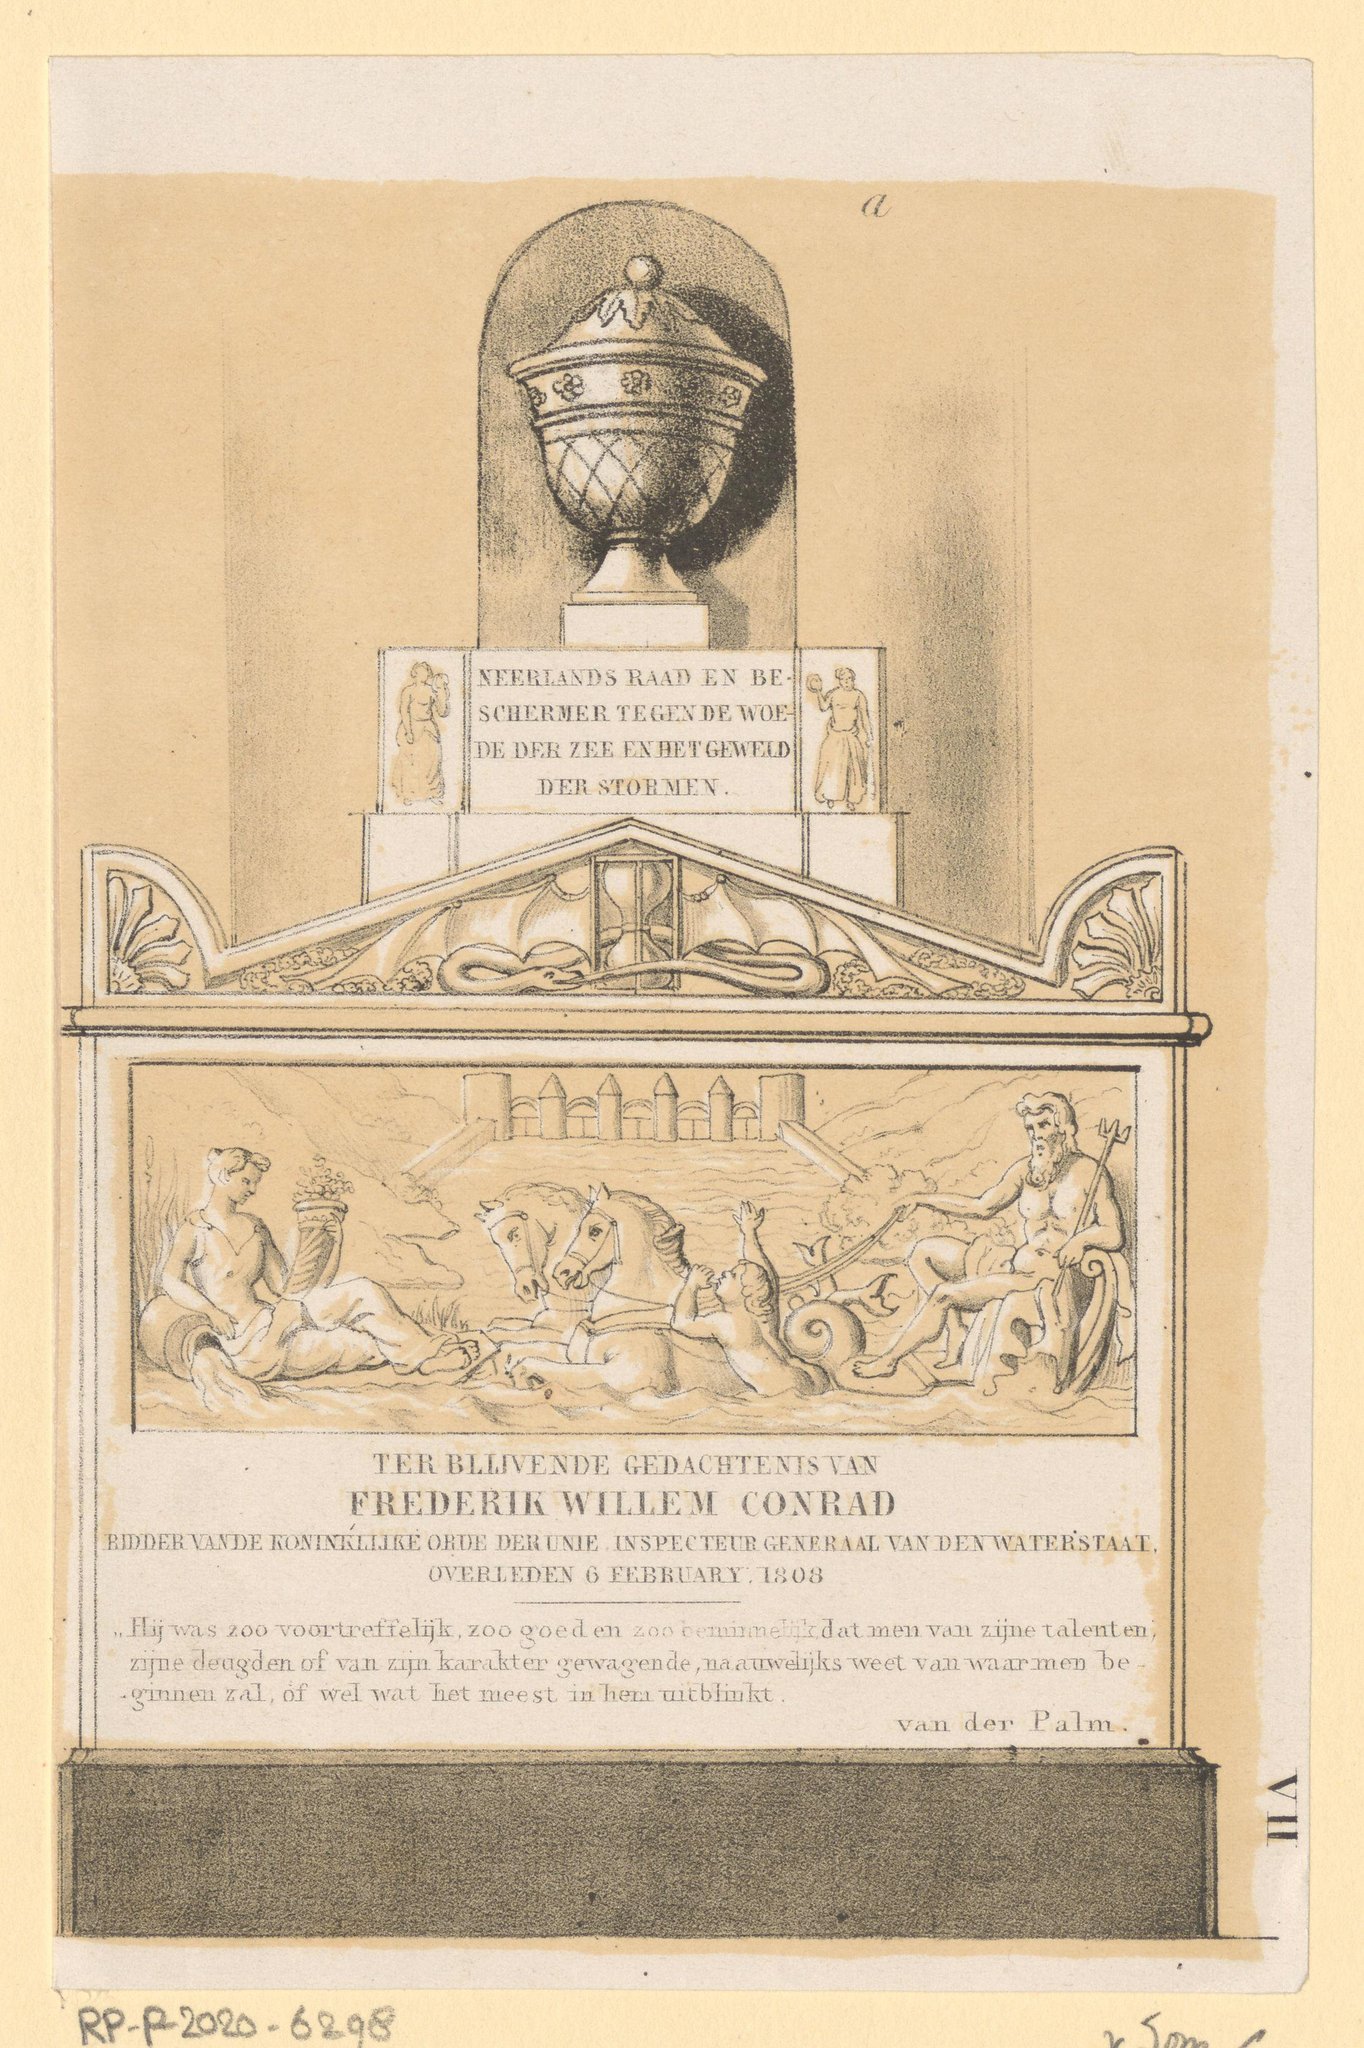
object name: print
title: Grafmonument van Frederik Willem Conrad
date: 1808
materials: paper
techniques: lithograph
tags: delft, grave, tomb